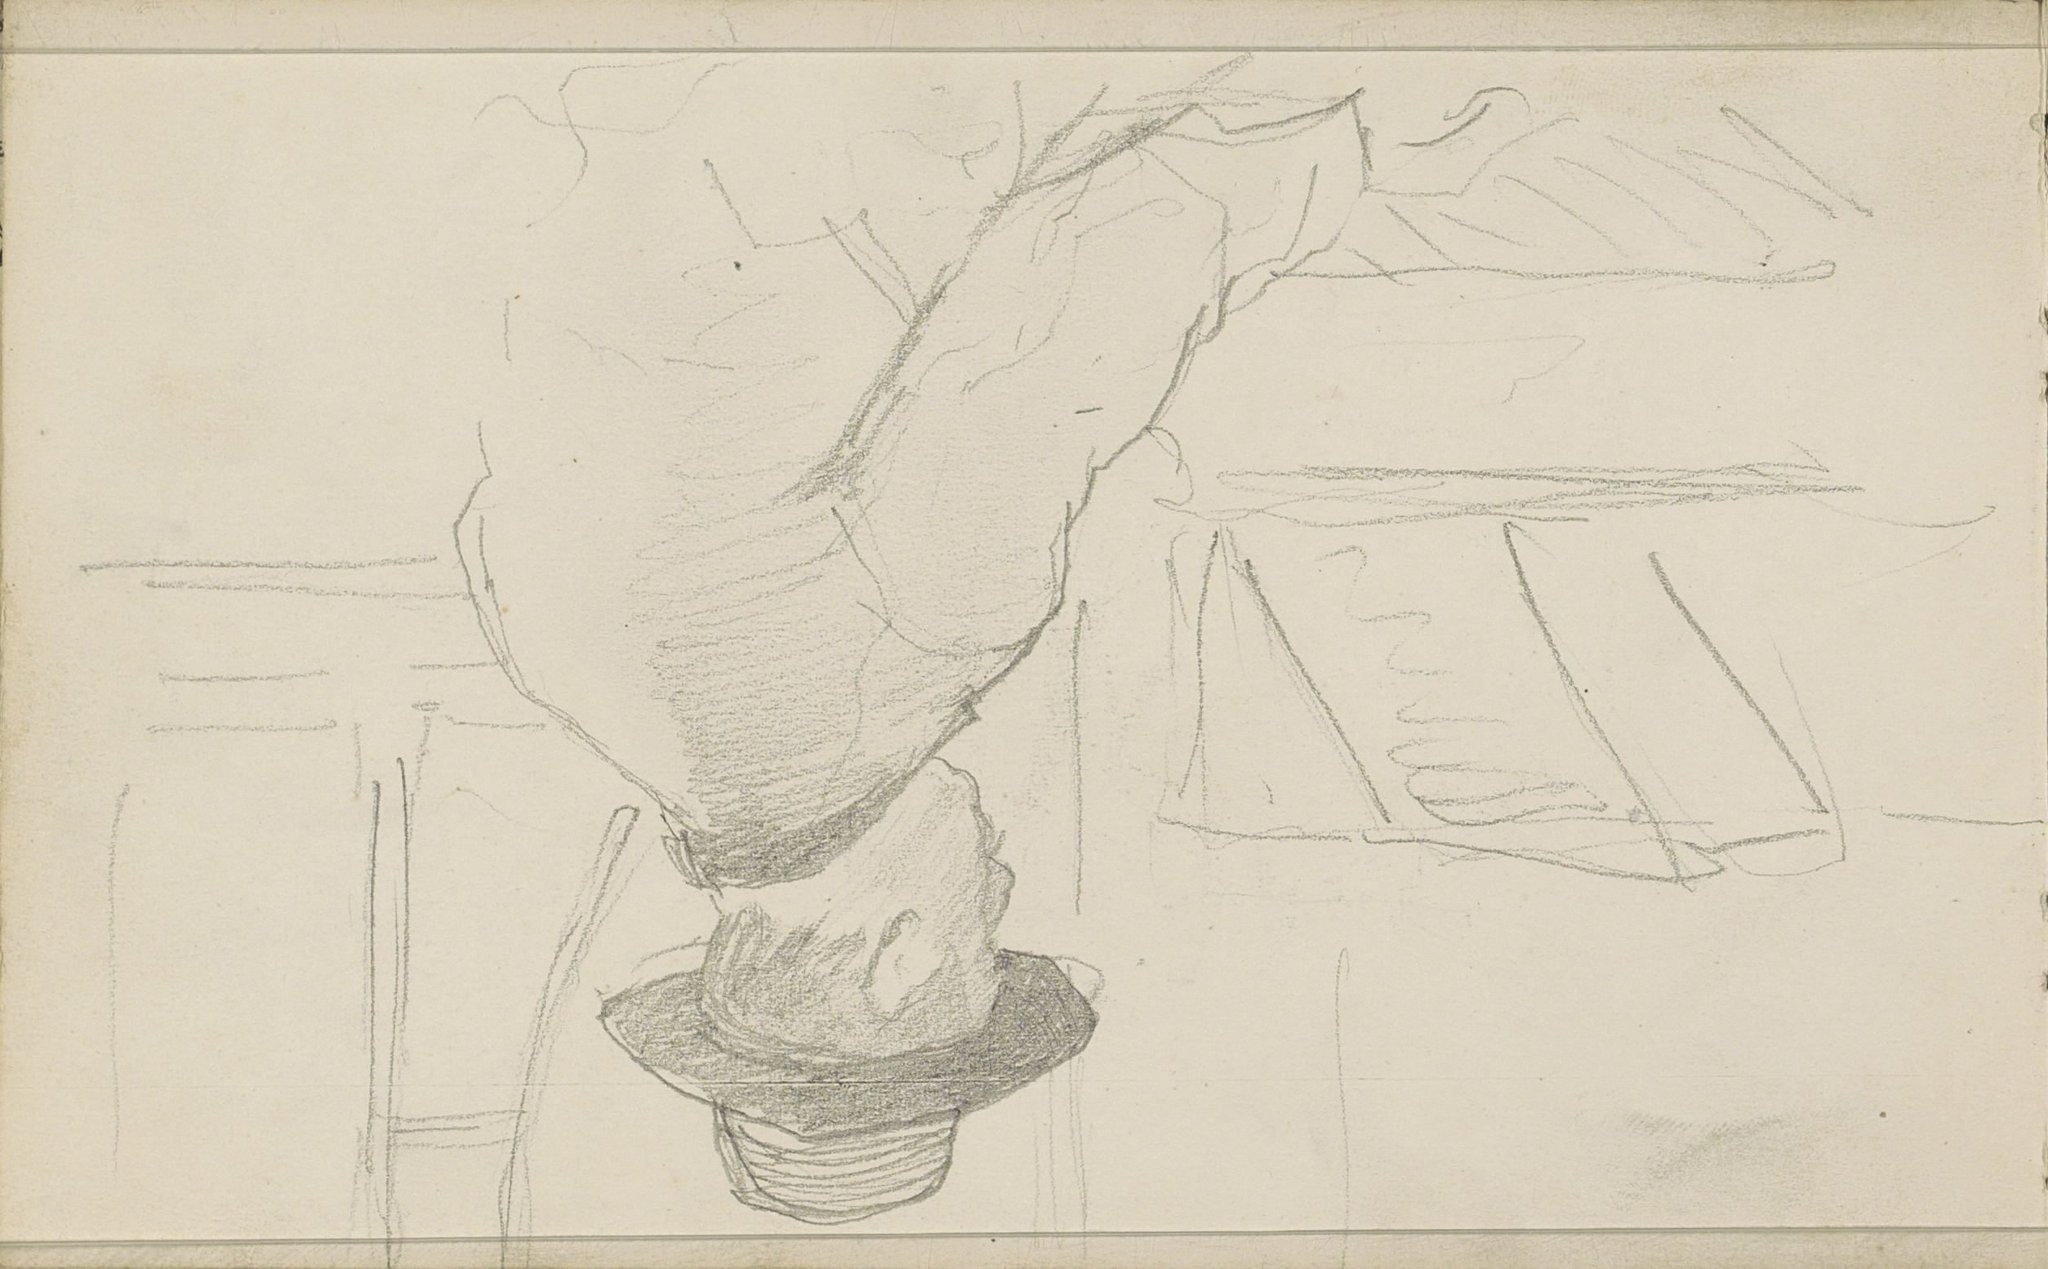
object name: sketchbook leaf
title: Pianospelende man met een hoge hoed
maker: anton mauve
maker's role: draughtsman, painter, print maker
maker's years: 1838-1888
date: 1848-1888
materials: paper, pencil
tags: one person playing keyboard instrument, grand piano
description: Blad 1 verso uit een schetsboek met 42 bladen.